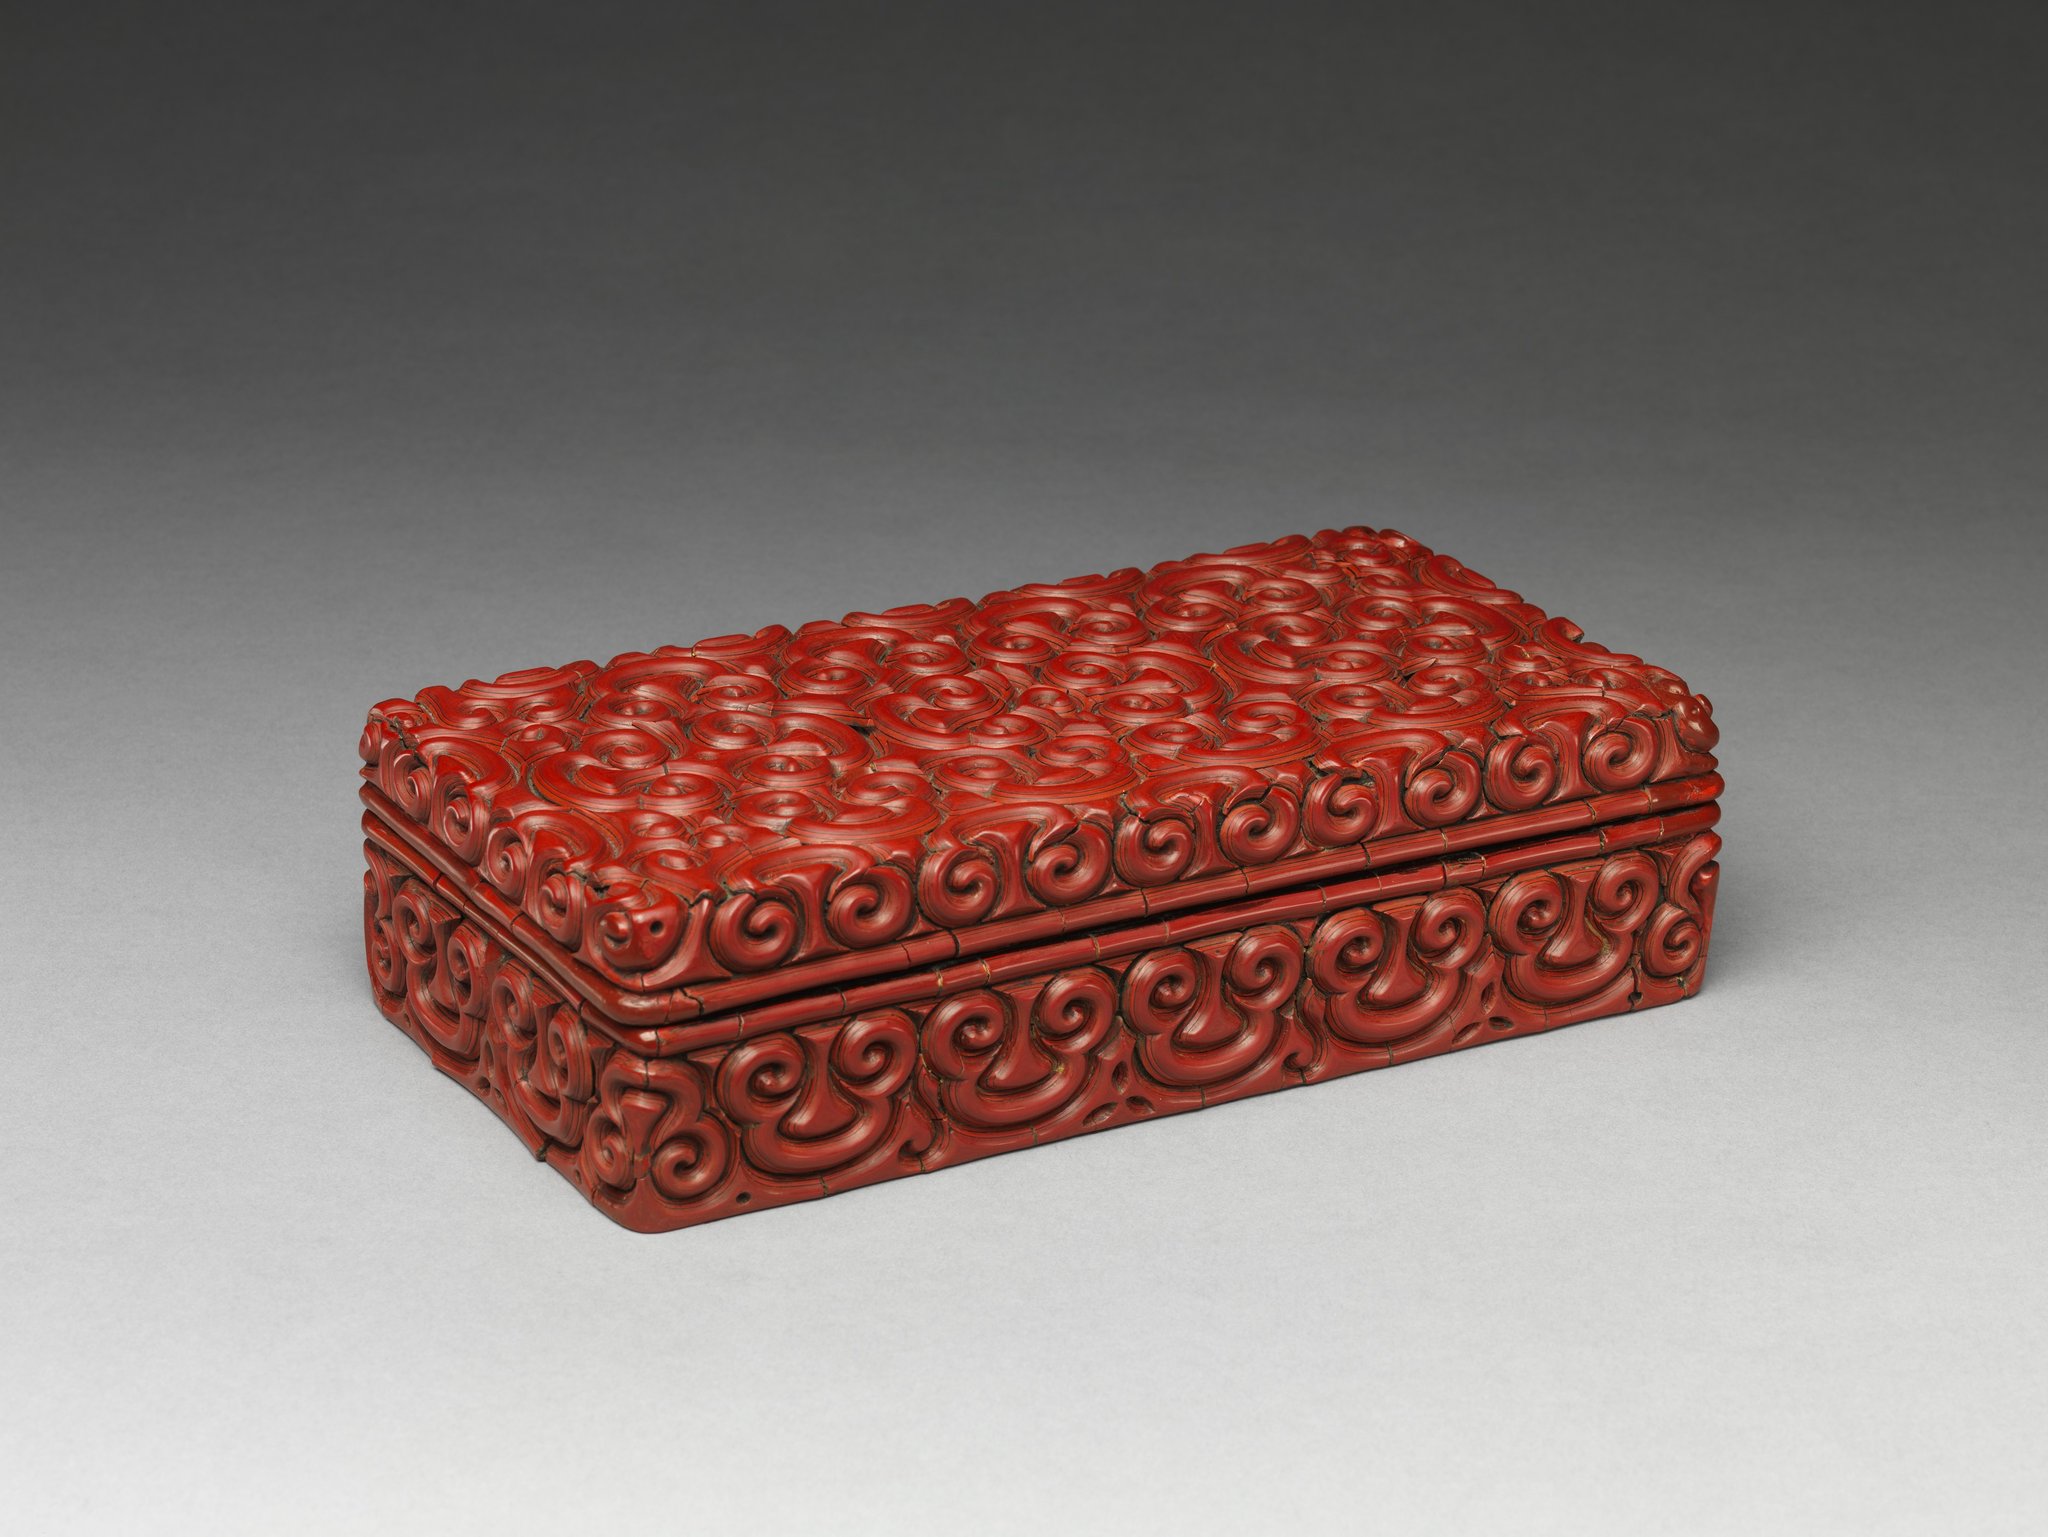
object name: box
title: Rectangular box with pommel scrolls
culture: chinese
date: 1301-1350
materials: lacquer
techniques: carving